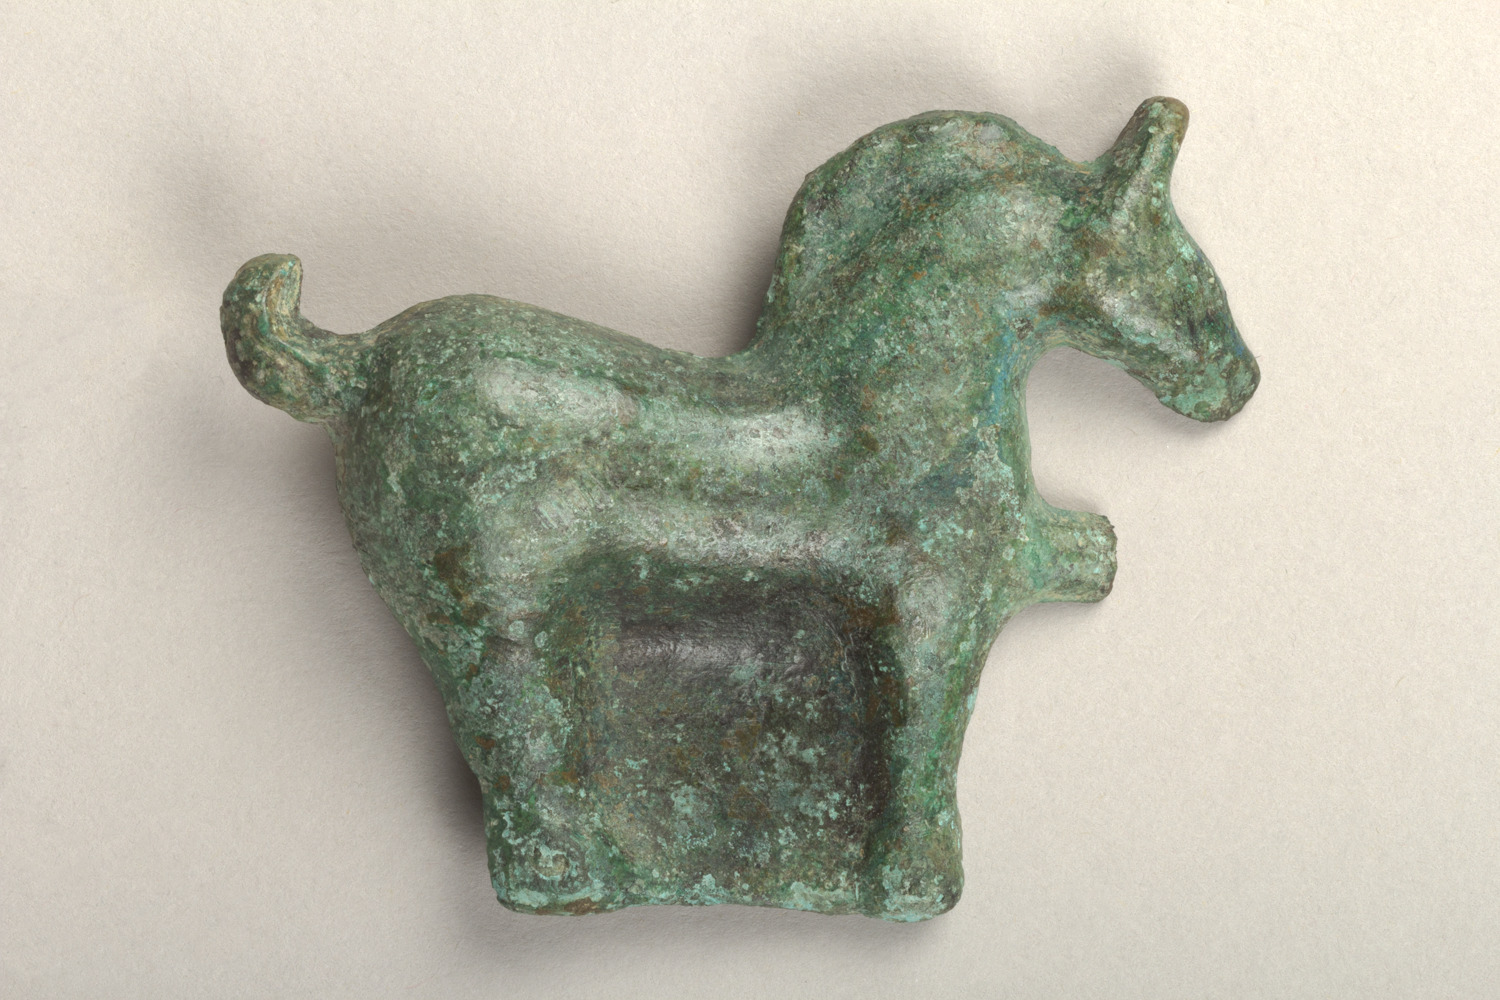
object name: belt buckle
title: Equine-shaped belt buckle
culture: korean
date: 101-300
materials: bronze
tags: horses